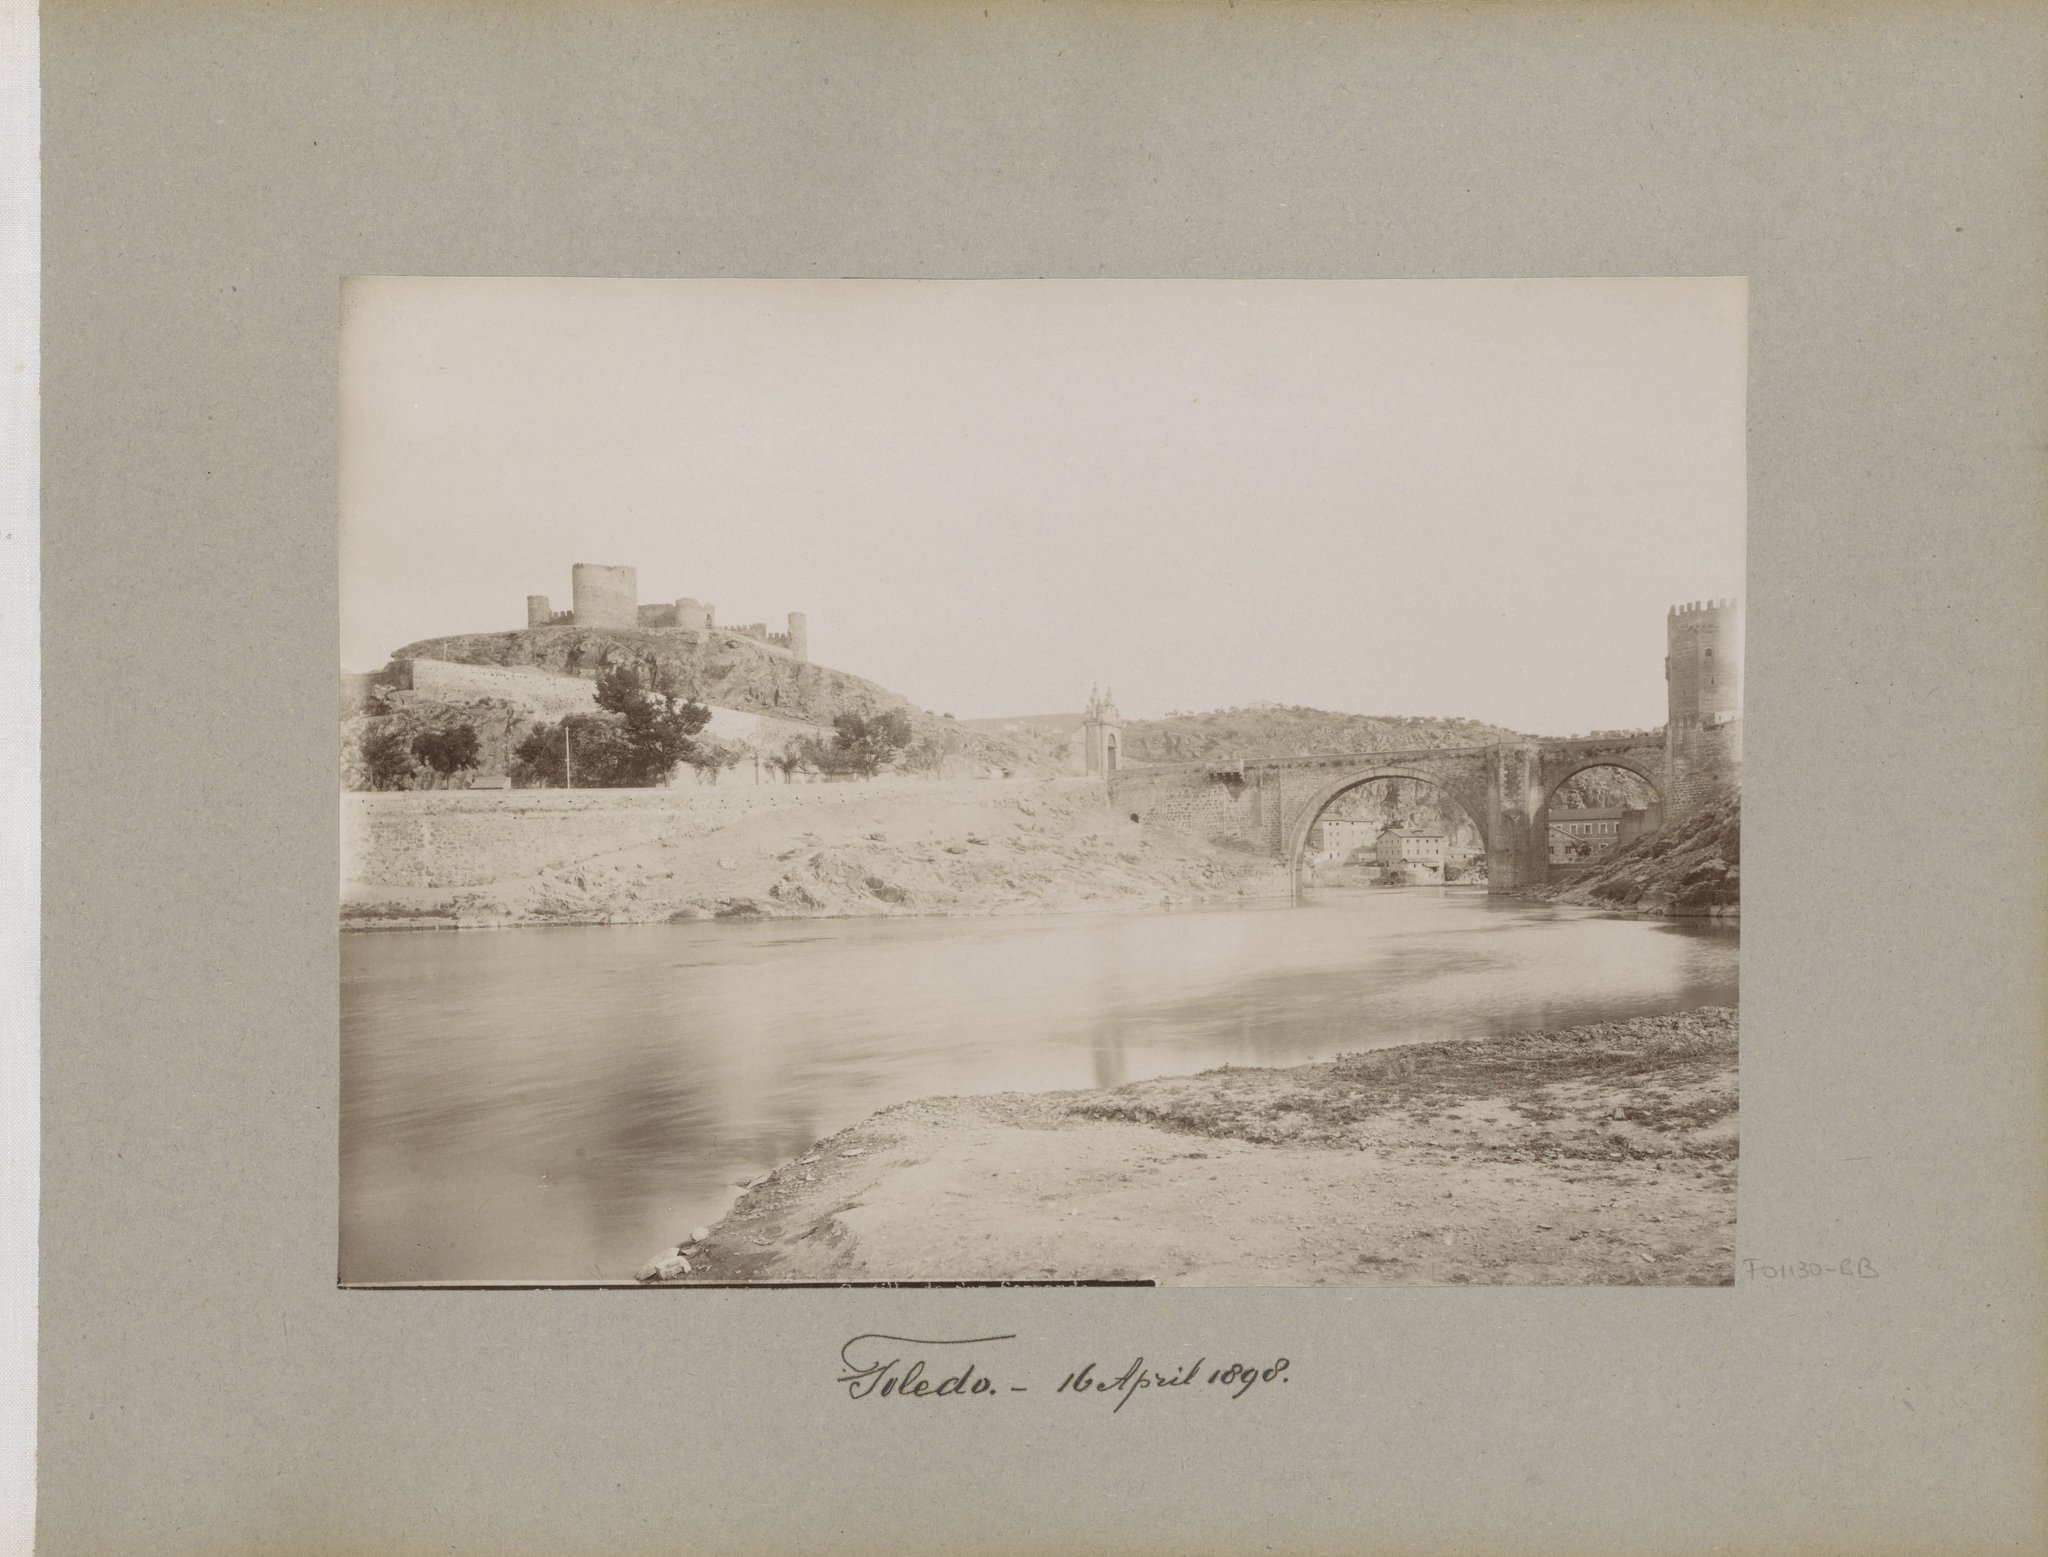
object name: album leaf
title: Toledo met brug en kasteel, gezien over de Taag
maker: Anonymous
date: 1880-1898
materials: paper, photographic support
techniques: albumen print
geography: toledo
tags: bridge in city across river, canal, etc., prospect of city, town panorama, silhouette of city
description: Onderdeel van Reisalbum met foto's van bezienswaardigheden in Frankrijk, Spanje, Italië, Duitsland, Zwitserland en Oostenrijk.